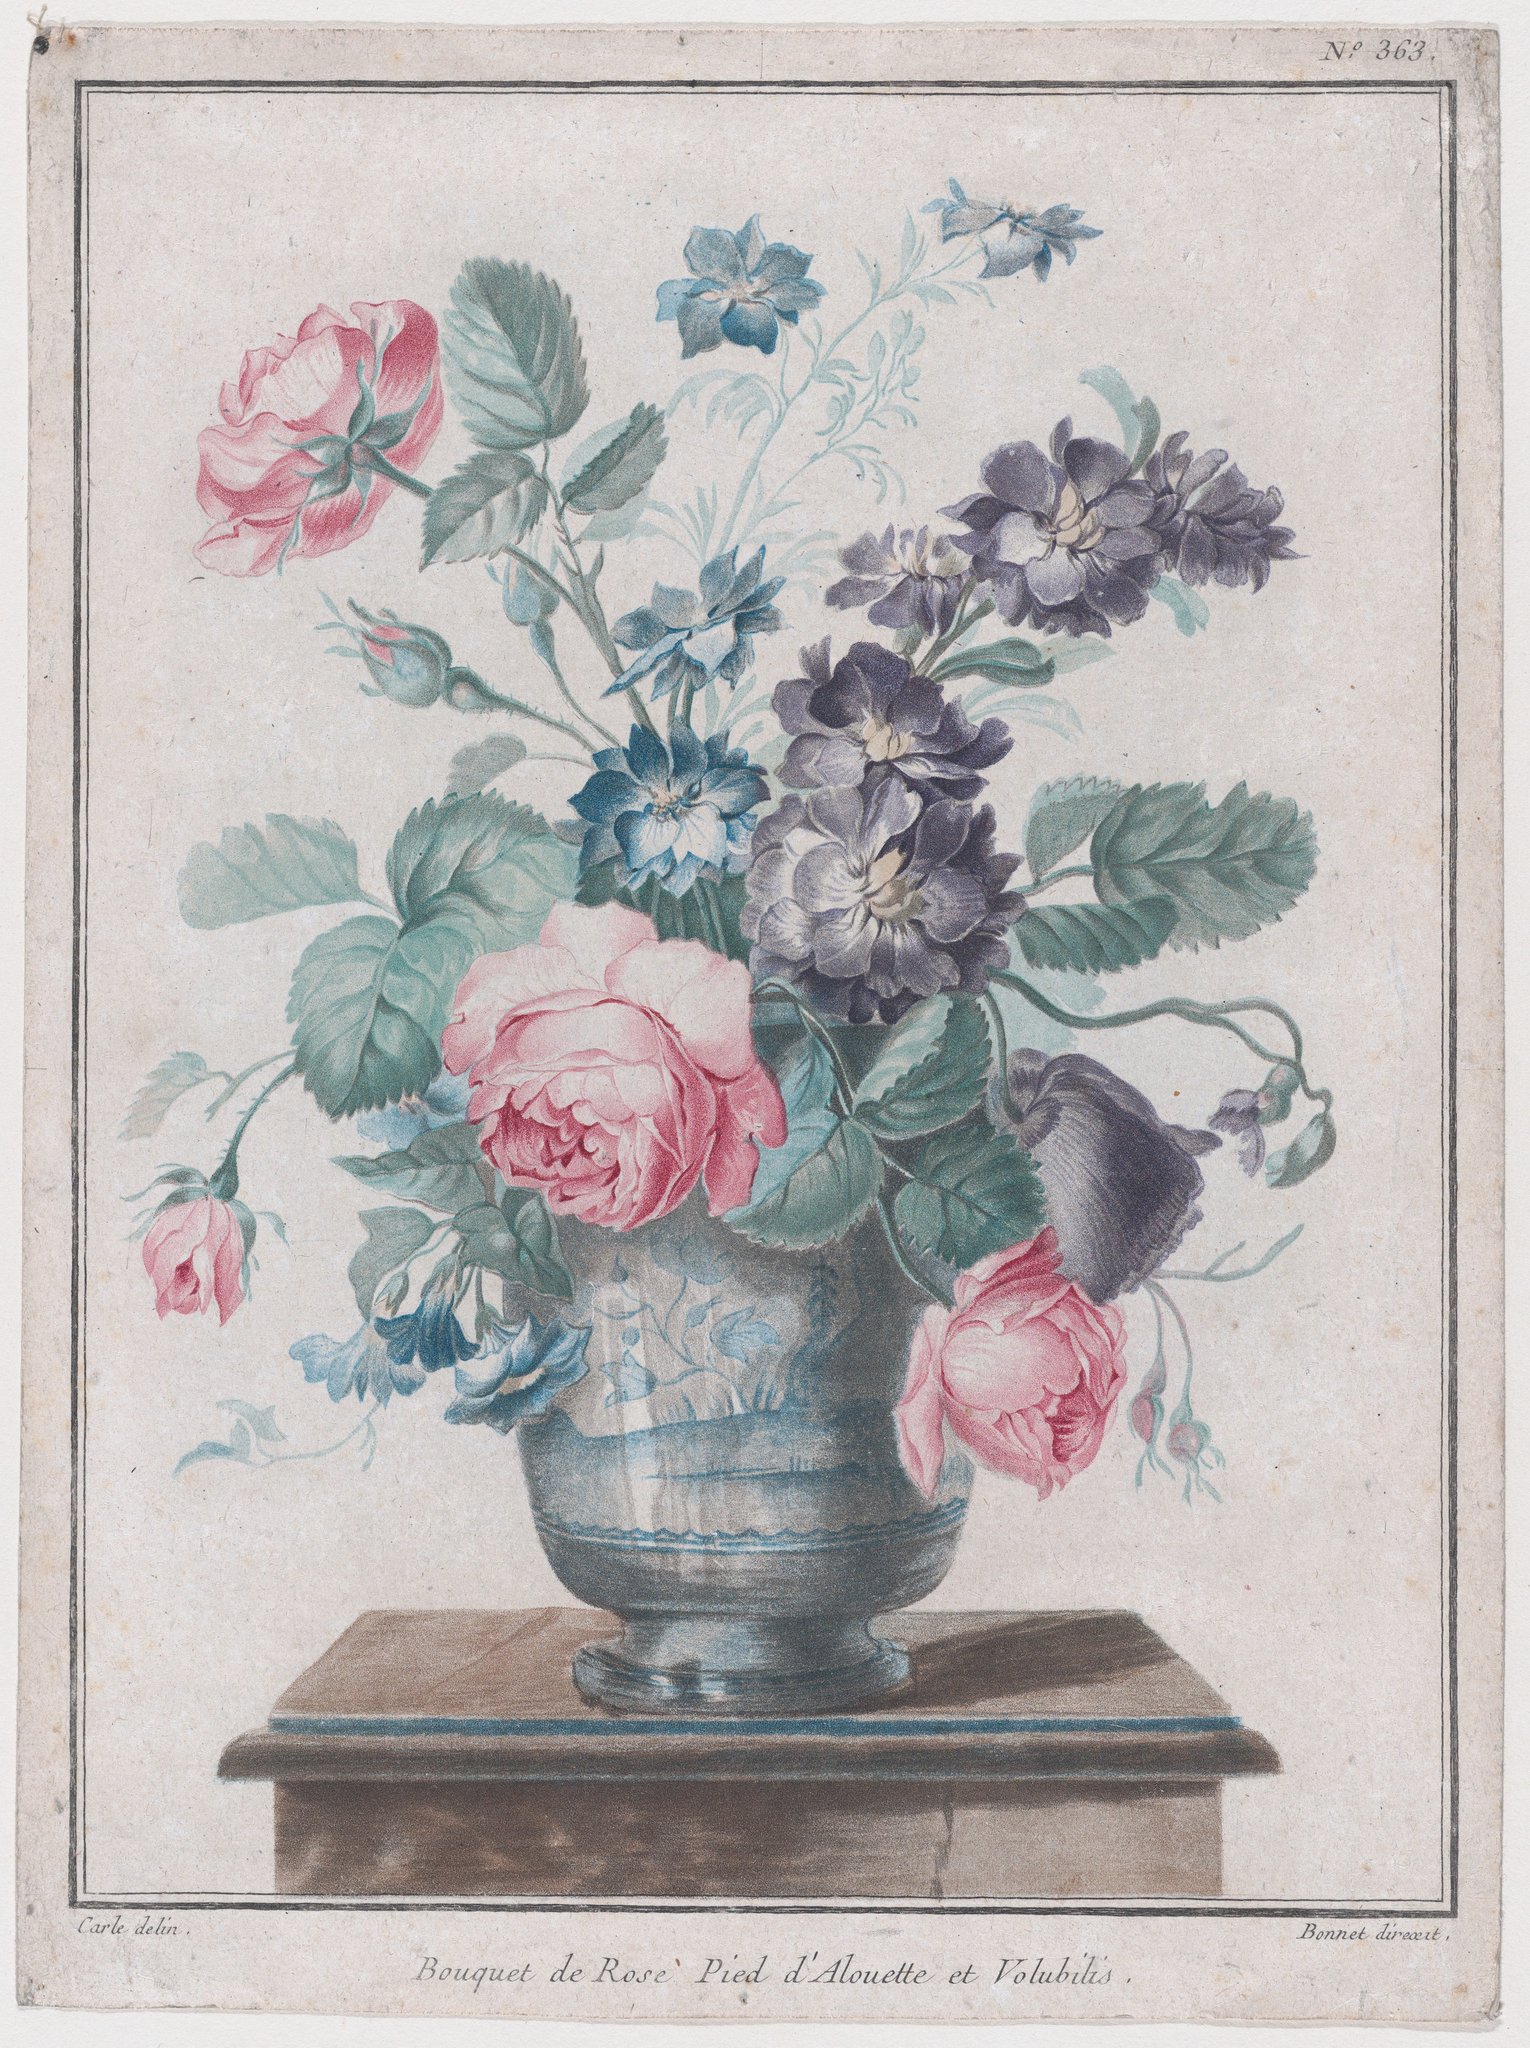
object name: print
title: Bouquet of Roses, Larkspur and Convolvulus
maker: louis marin bonnet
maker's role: artist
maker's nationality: french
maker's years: 1736-1793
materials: pastel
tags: roses,leaves,vases